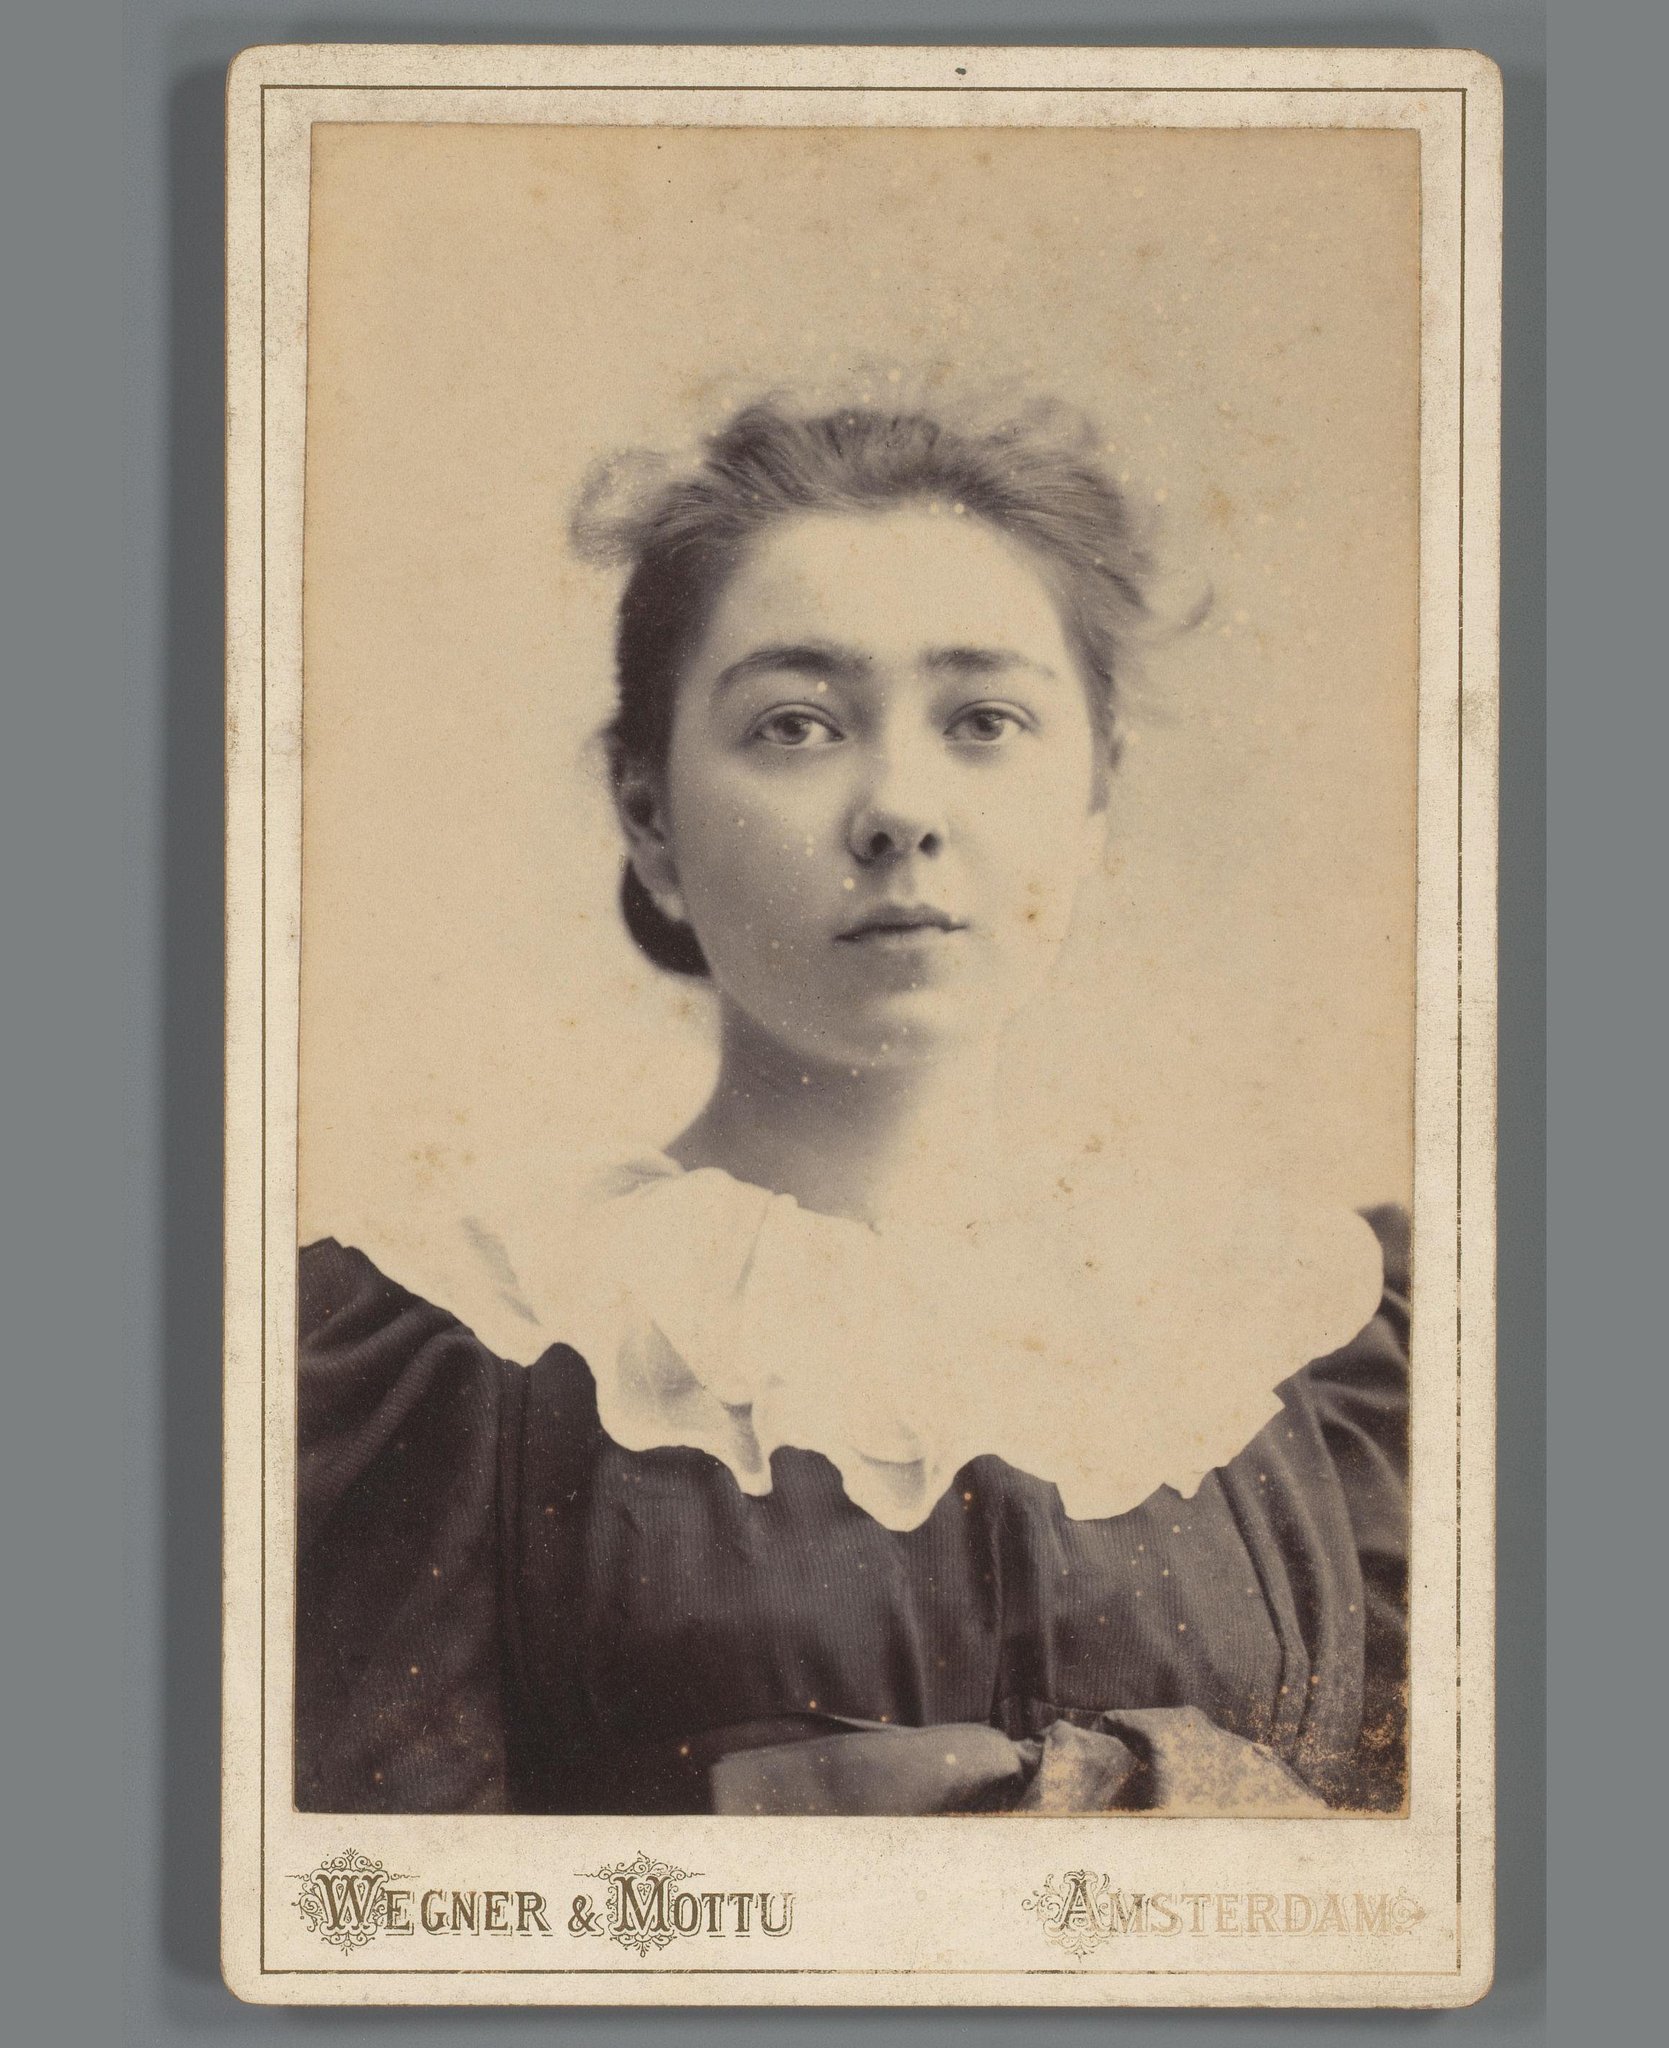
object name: photograph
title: Portret van Lizzy Ansingh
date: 1890-1900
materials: cardboard, paper, photographic support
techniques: albumen print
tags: utrecht, print maker, draughtsman, lizzy ansingh, historical persons - bb - woman, portrait, self-portrait of painter